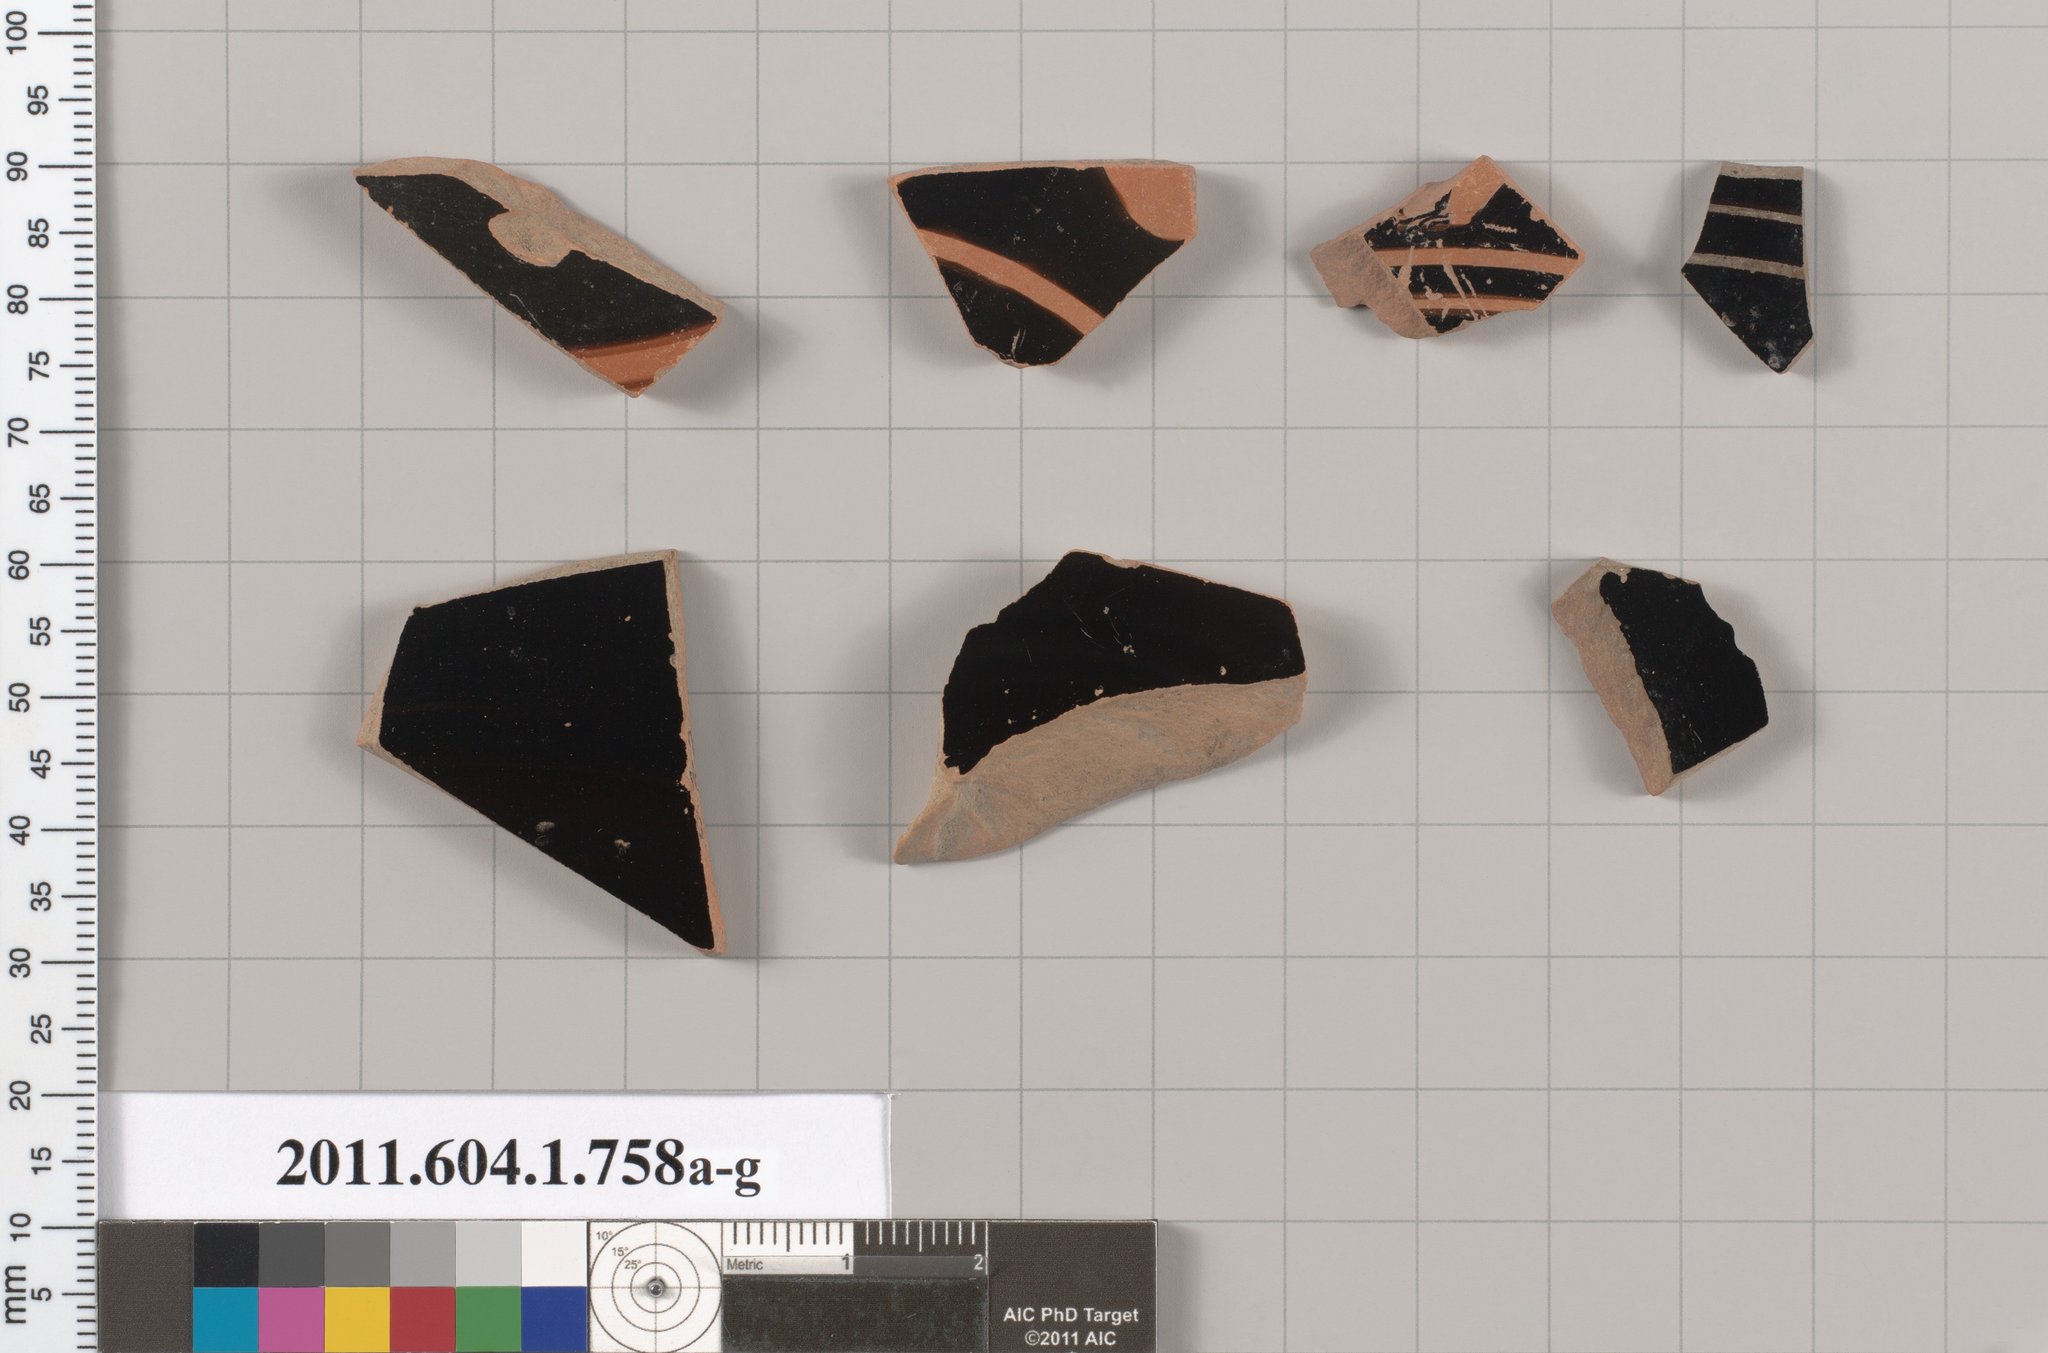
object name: kylix fragment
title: Terracotta fragments of kylikes (drinking cups)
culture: greek, attic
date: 500-401 BCE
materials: terracotta